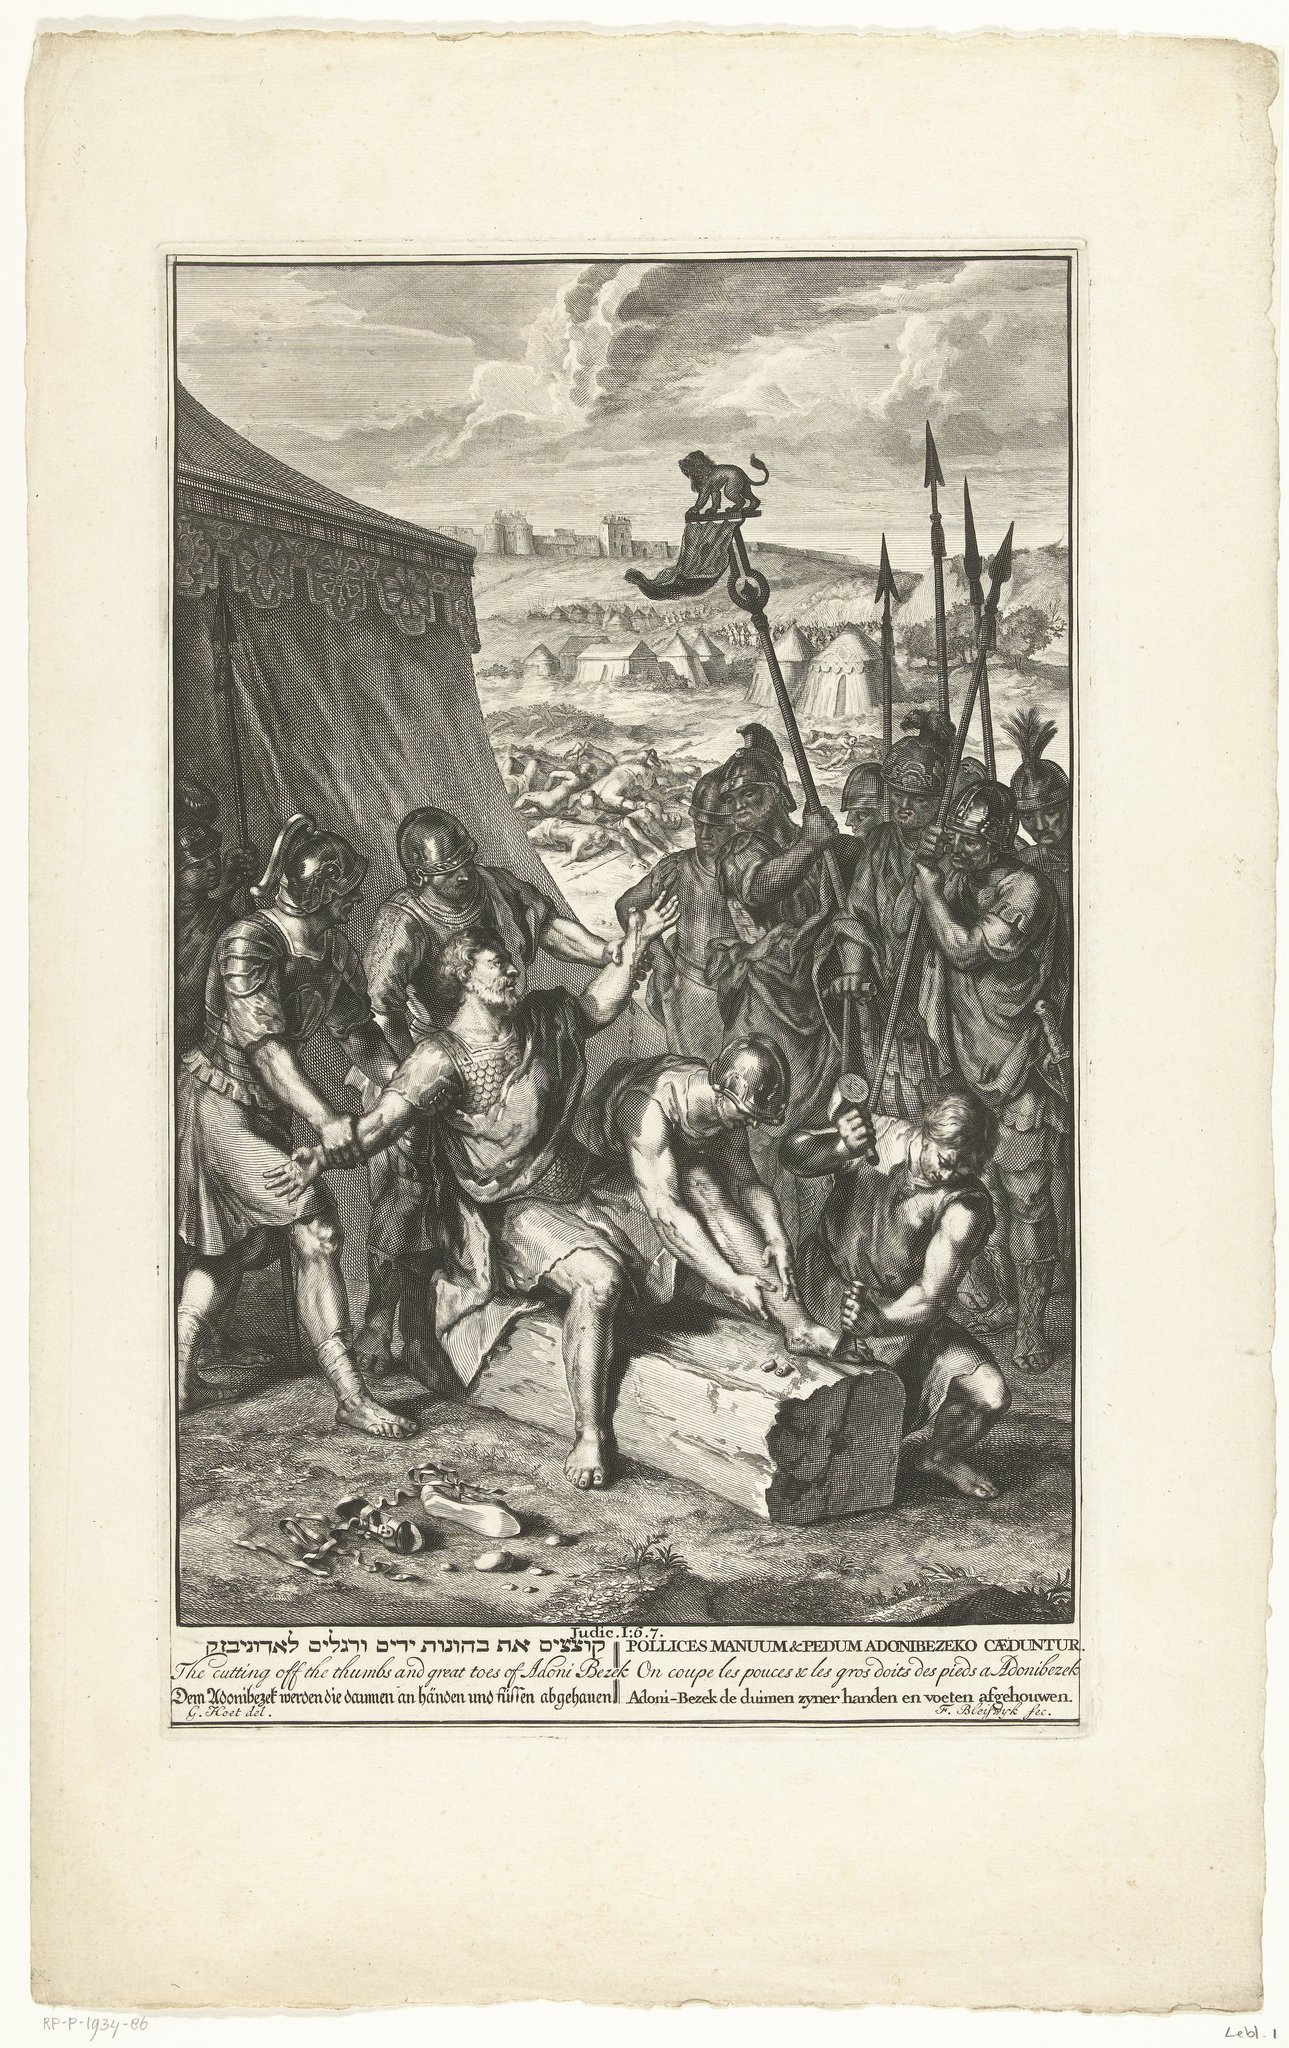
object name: print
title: Soldaten hakken duimen en grote tenen van Adonibezek af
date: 1720-1728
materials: paper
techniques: engraving, etching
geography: leiden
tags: adoni-bezek is caught; his thumbs and his great toes are cut off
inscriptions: collector's mark: Lugt 2228, inscription: ‘utrechts Fundatie huijs’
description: Prent gemaakt voor: Figures de la Bible. Amsterdam, Bernard Picart, 1720. Prent ook gebruikt in: Taferelen der voornaamste geschiedenissen van het Oude en Nieuwe Testament (...) door de vermaarde kunstenaars Hoet, Houbraken, en Picart getekent (...) en met beschrijvingen uitgebreid. Den Haag: Pieter de Hondt, 1728.